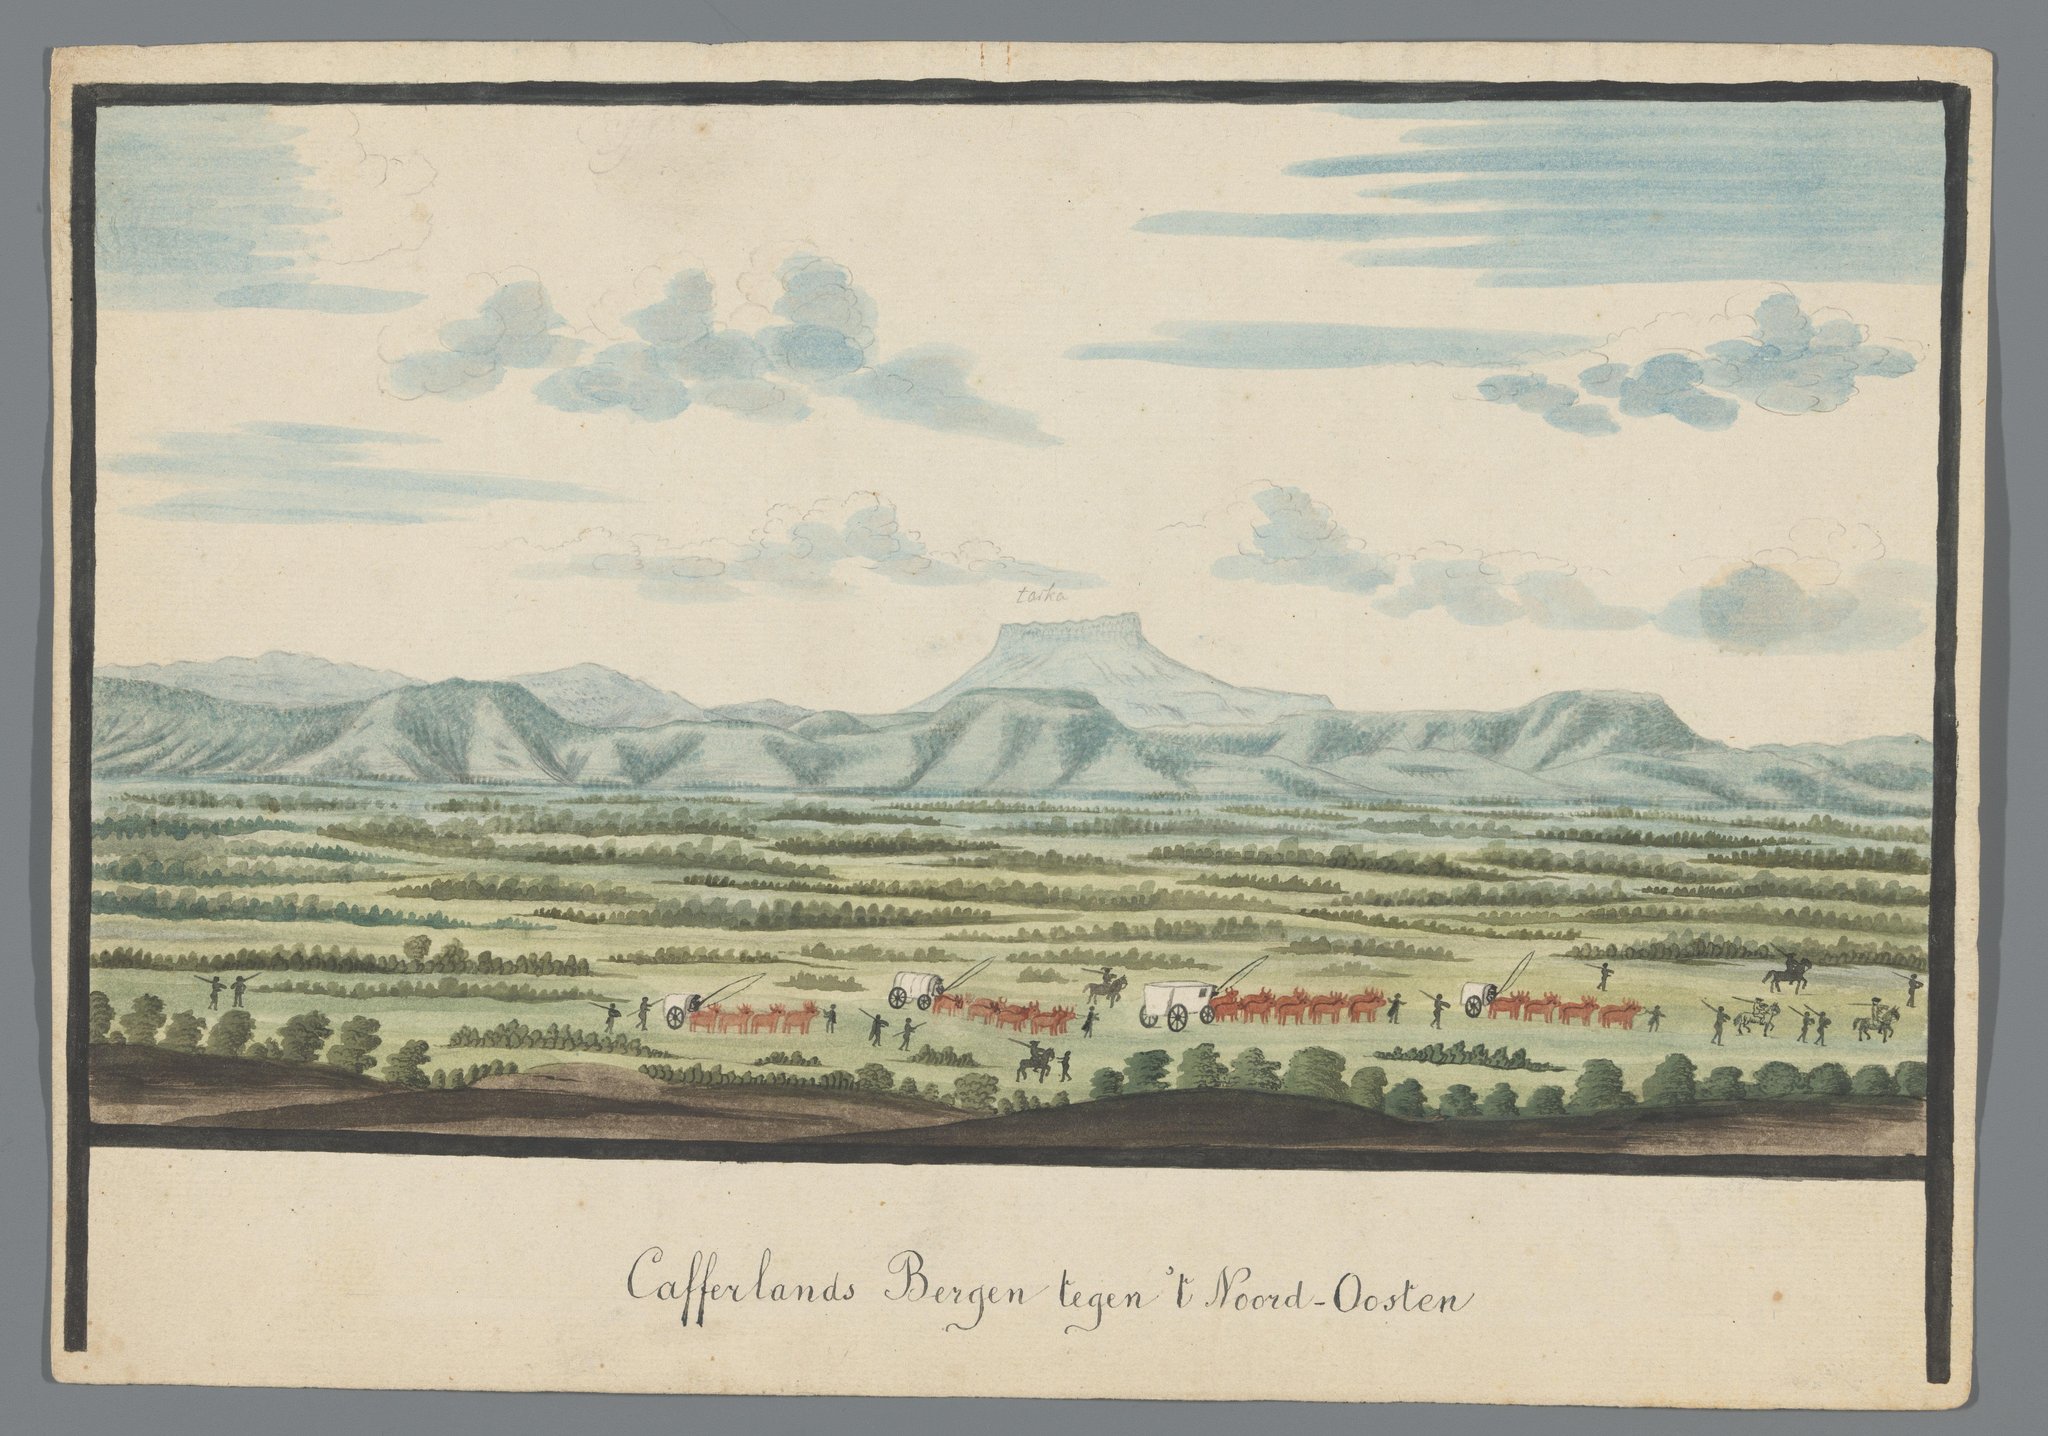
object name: drawing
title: Cafferlands Bergen tegen 't Noord-Oosten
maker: johannes schumacher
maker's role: draughtsman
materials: paper, watercolor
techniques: brush, pen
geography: south africa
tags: cape of good hope, covered wagon, hooded wagon, mountain-range, snow peaks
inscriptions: label: ‘30’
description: Gezicht op het terrein naar de Amathole gebergte (Amathole Mountains), het land van de Xhosa aan de overzijde van de Grote Visrivier. In de verte de afgevlakte bergtop van de Gaika's Kop. Op de voorgrond de karavaan van ossenwagens. Tekening gemaakt tijdens de tweede reis van Hendrik Swellengrebel, naar het noordoosten van de Kaapkolonie, 10 september - 26 december 1776. Volgens het reisjournaal werd deze streekt eind oktober - begin november 1776 bezocht.